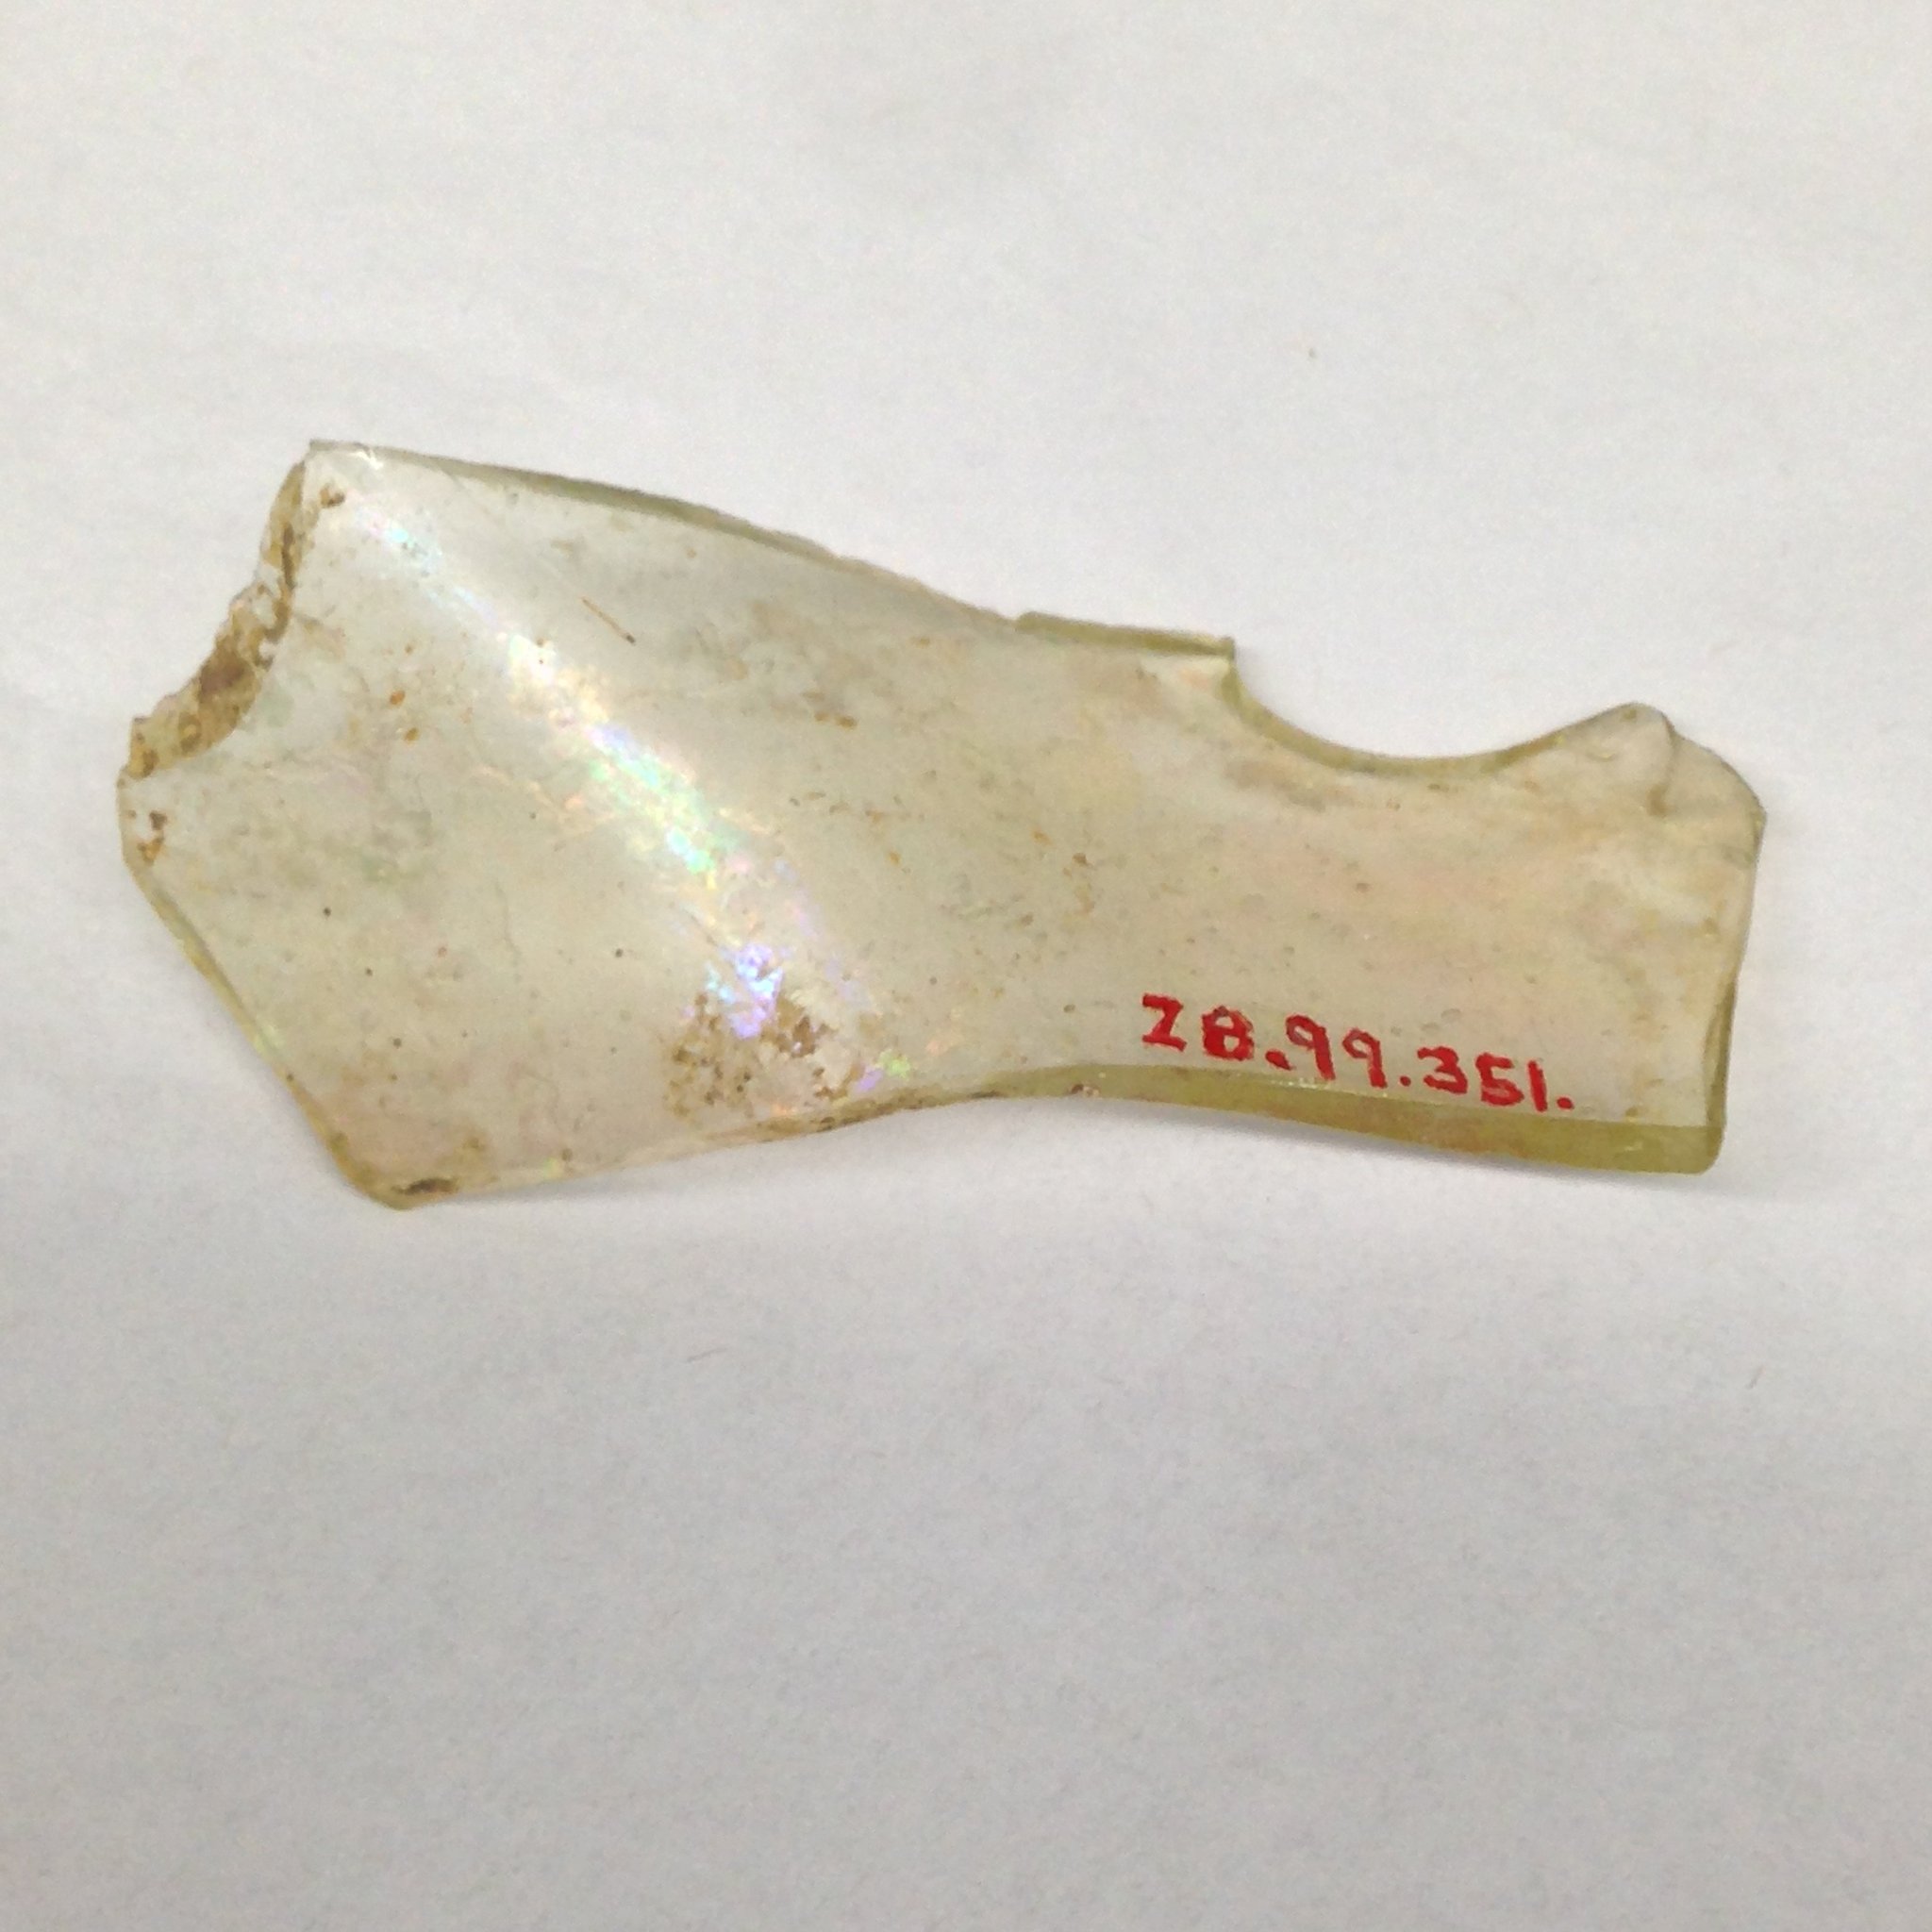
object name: fragment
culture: european or middle eastern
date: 1150-1250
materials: ceramic, glass